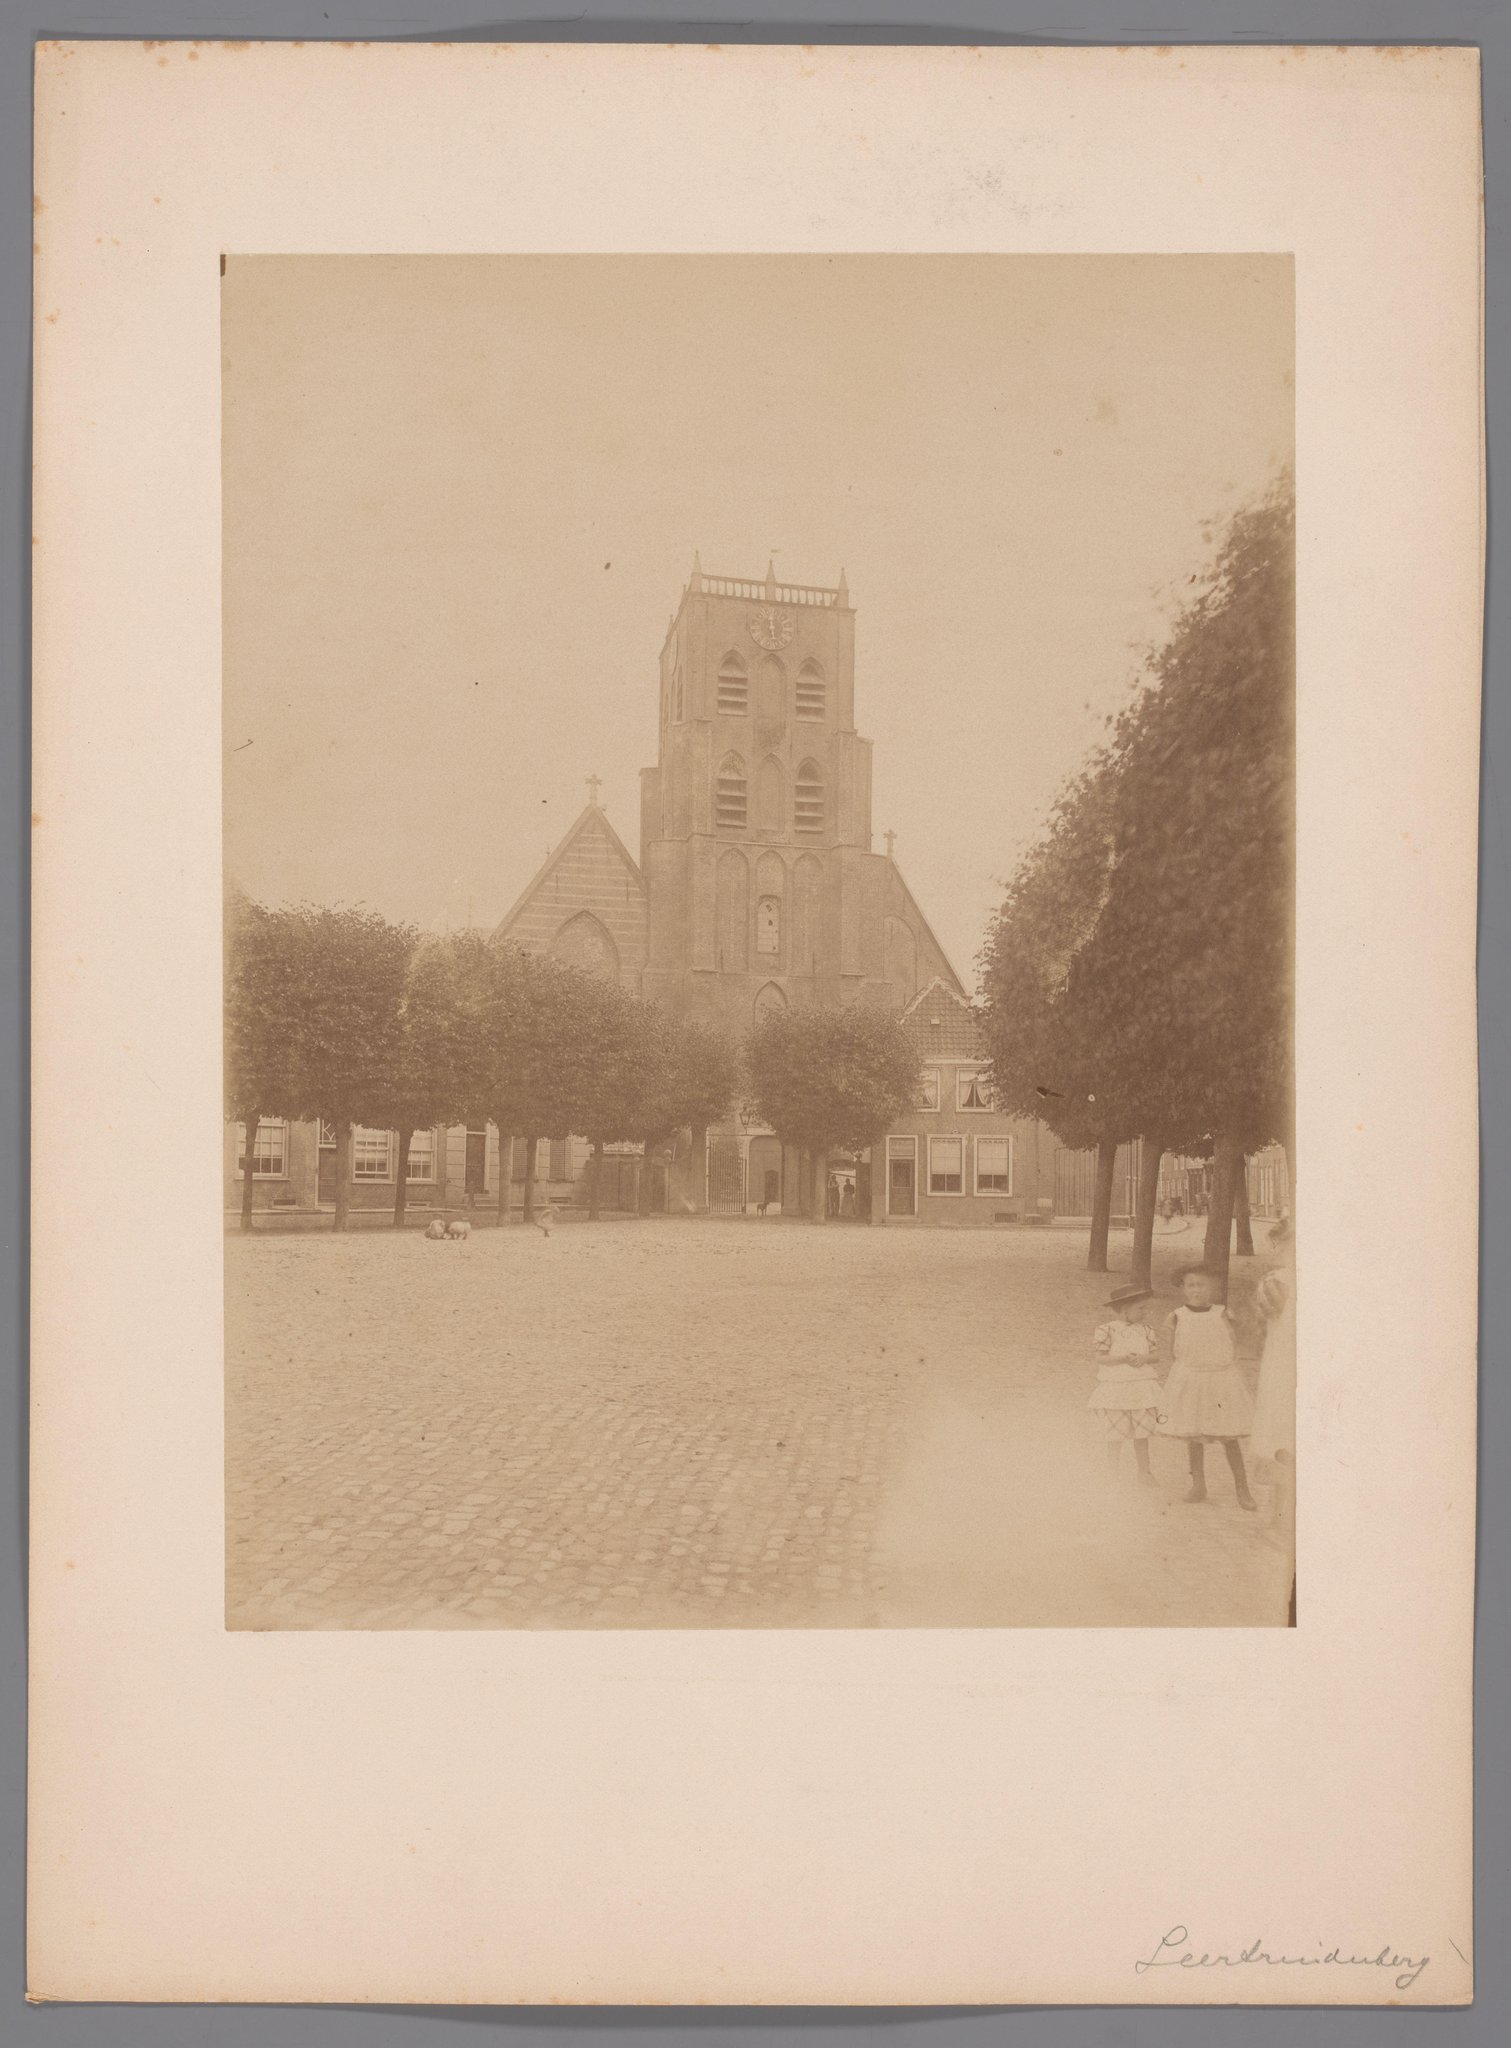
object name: photograph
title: Gezicht op de Geertruidskerk te Geertruidenberg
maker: anoniem (monumentenzorg)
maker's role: fotograaf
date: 1895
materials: cardboard, photographic support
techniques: albumen print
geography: geertruidenberg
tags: square, place, circus, etc., church (exterior), geertruidenberg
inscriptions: annotation: ‘Geertruidenberg (N.B.)/ Kerk v/d N.H. gemeente/ sept 1895/ Top: A’, annotation: ‘Geertruidenberg’